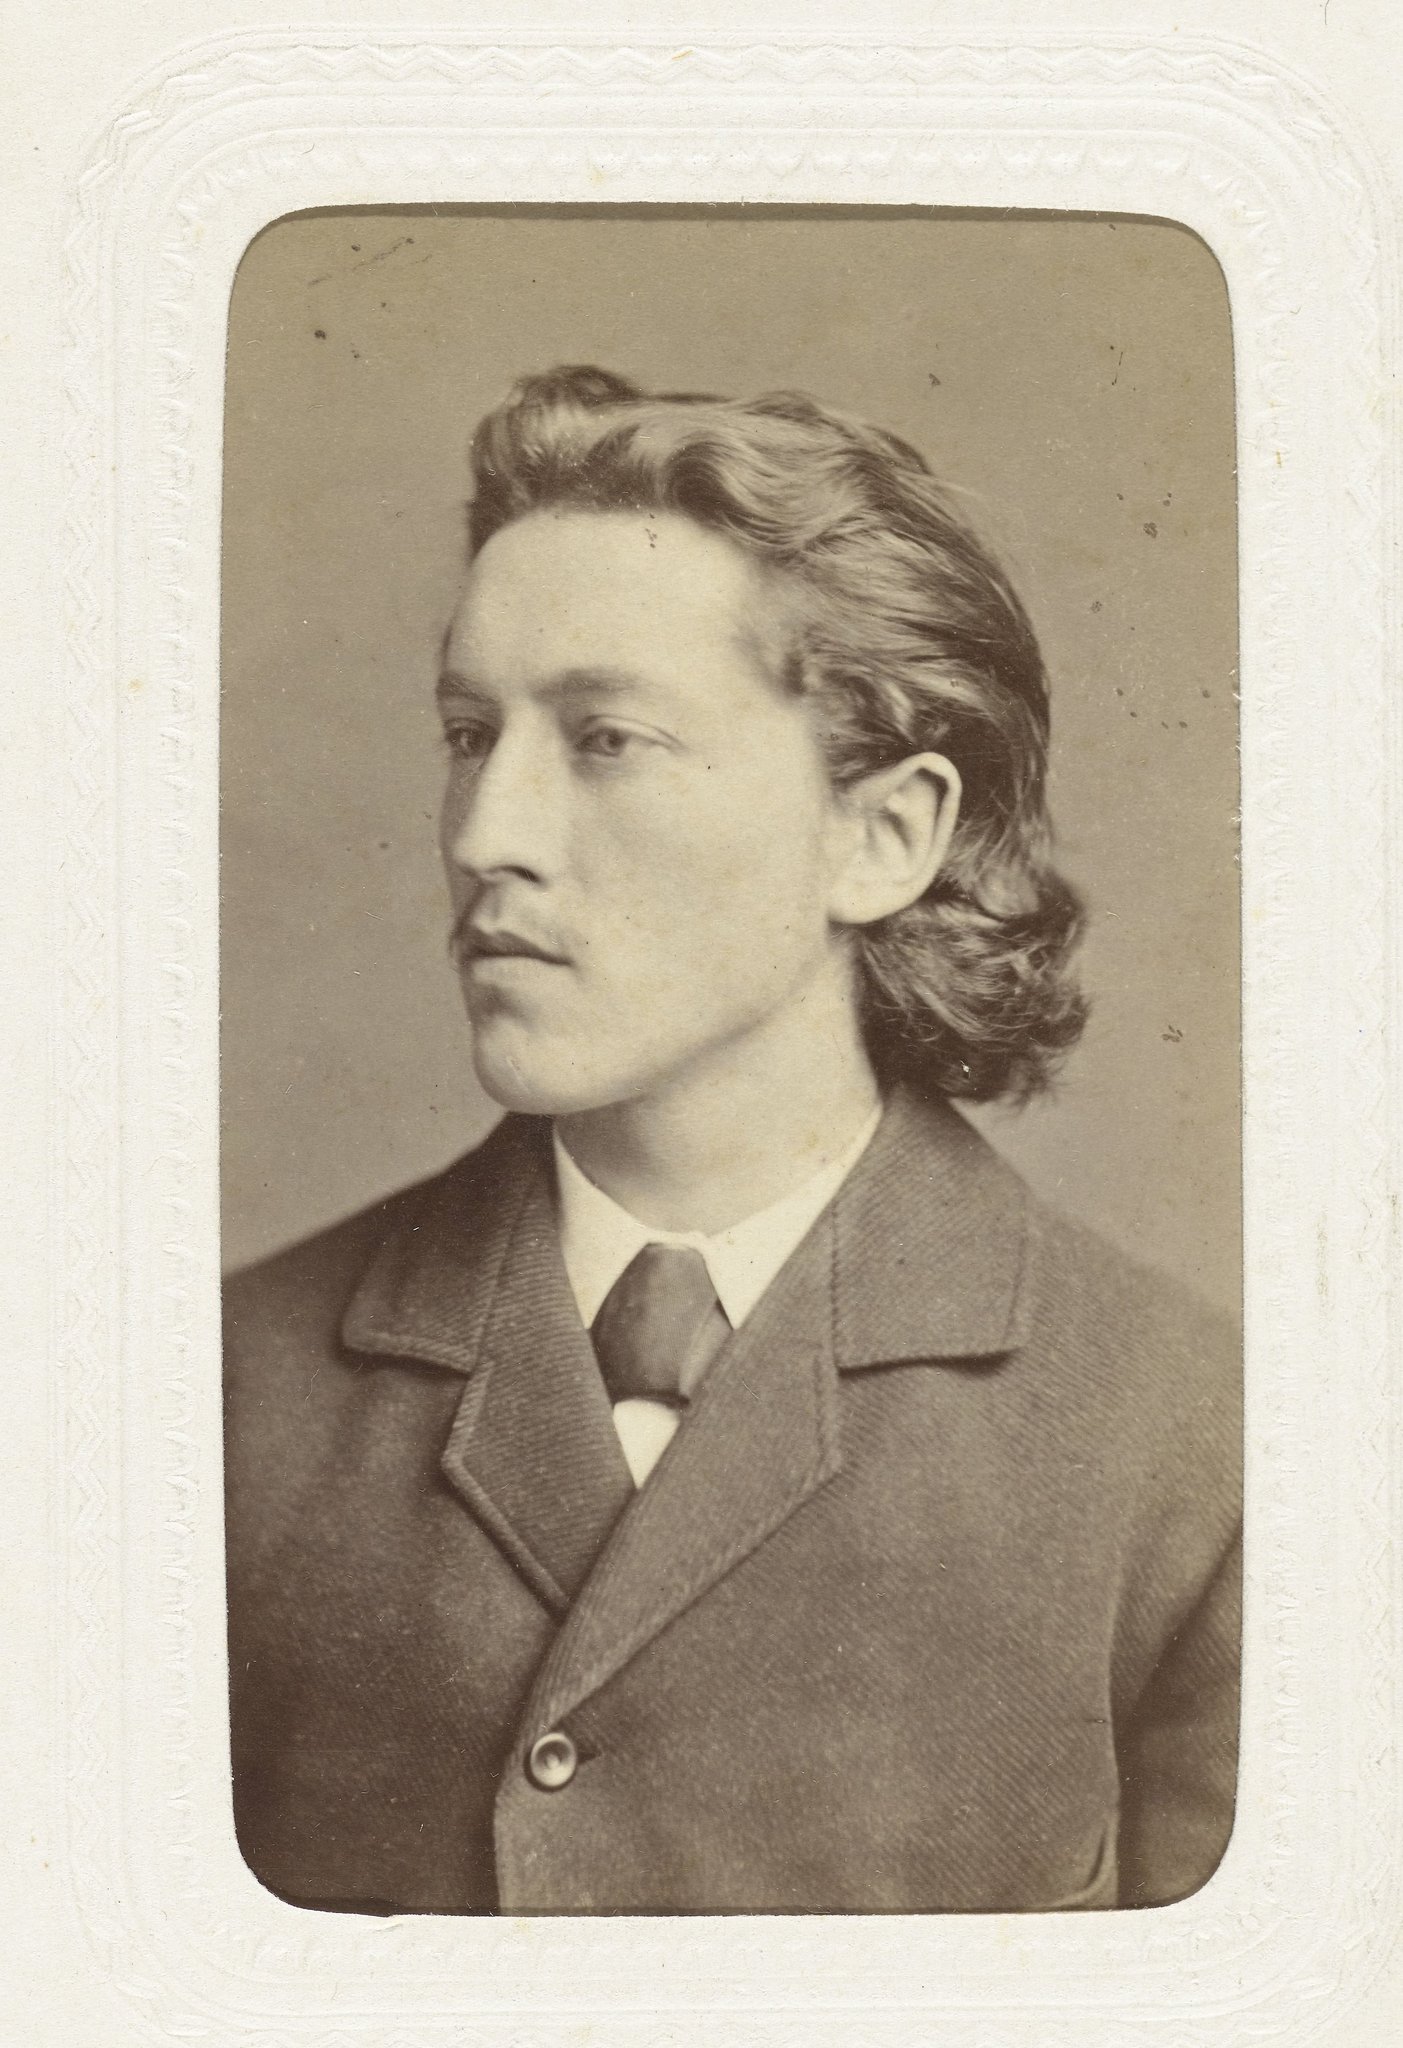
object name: carte de visite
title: Studioportret van een jonge man met half lang haar en een vlassige snor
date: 1863-1866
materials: cardboard, paper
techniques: albumen print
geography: istanbul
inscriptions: name: ‘Albert Greiner, Amsterdam’